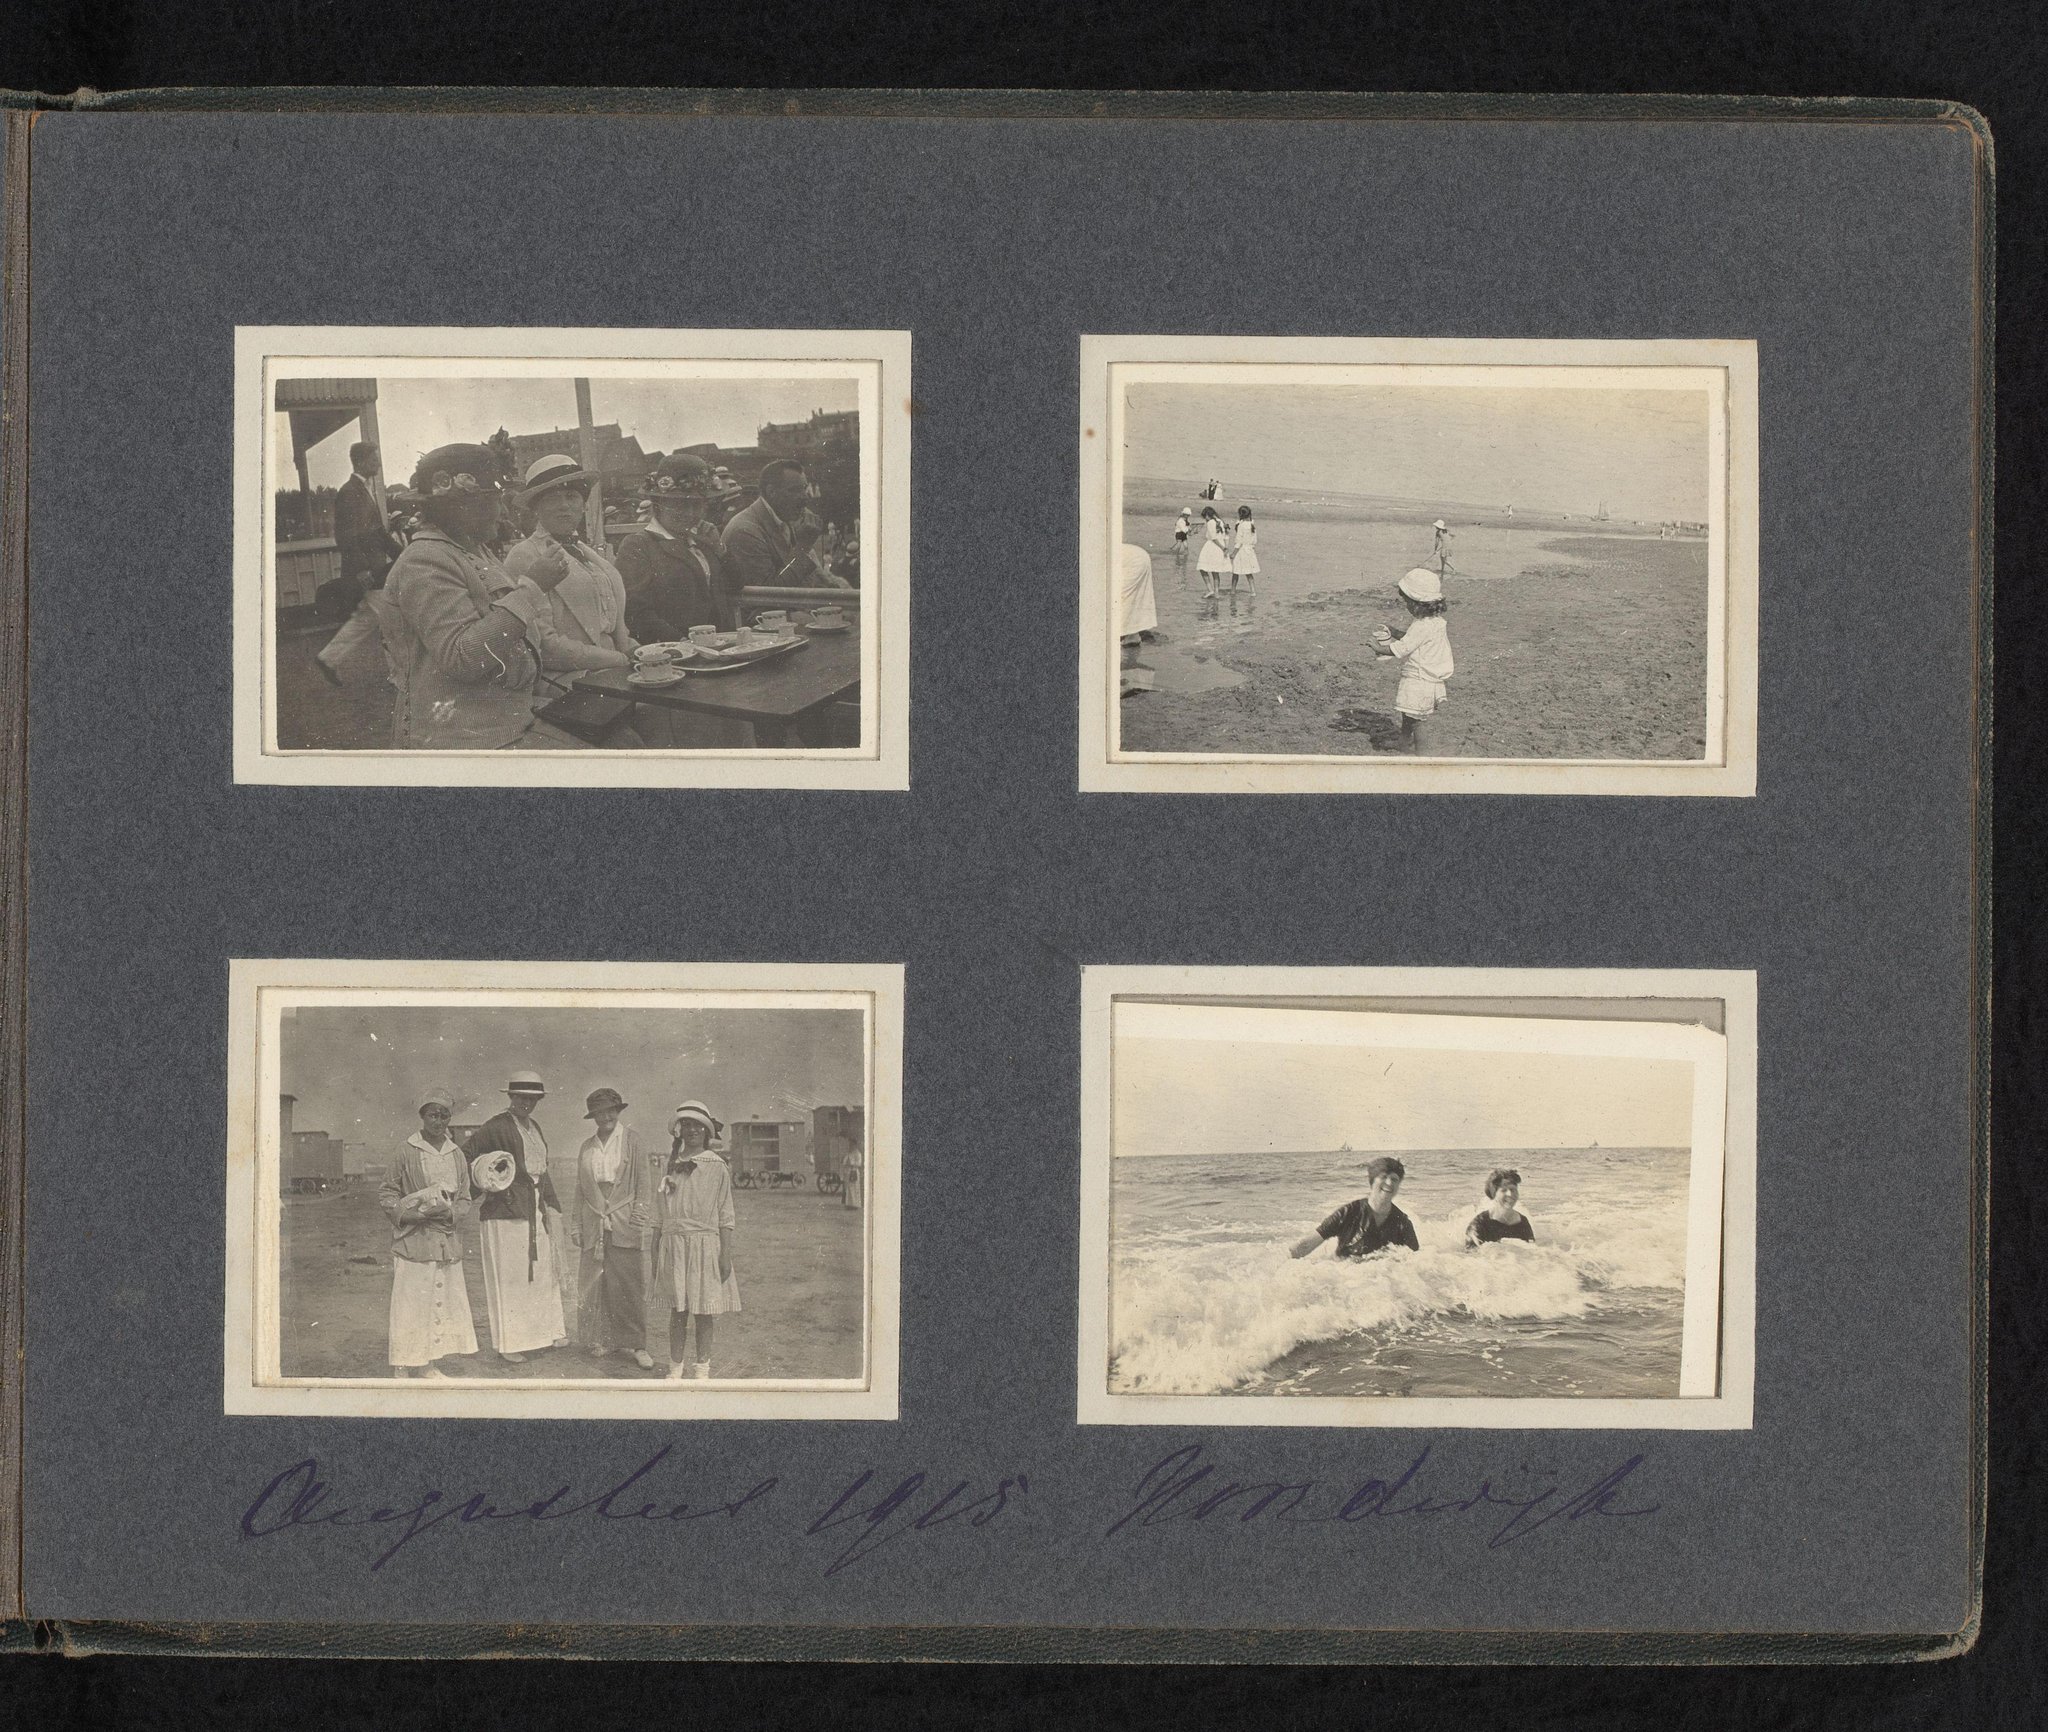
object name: photograph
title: Familie van den Berg op het strand in Noordwijk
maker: hendrik herman van den berg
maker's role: amateurfotograaf, jurist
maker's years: 1875-1944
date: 1908-1915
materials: paper, cardboard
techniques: gelatin silver print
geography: noordwijk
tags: beach (as place of recreation)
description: Deze foto's zijn onderdeel van een album.